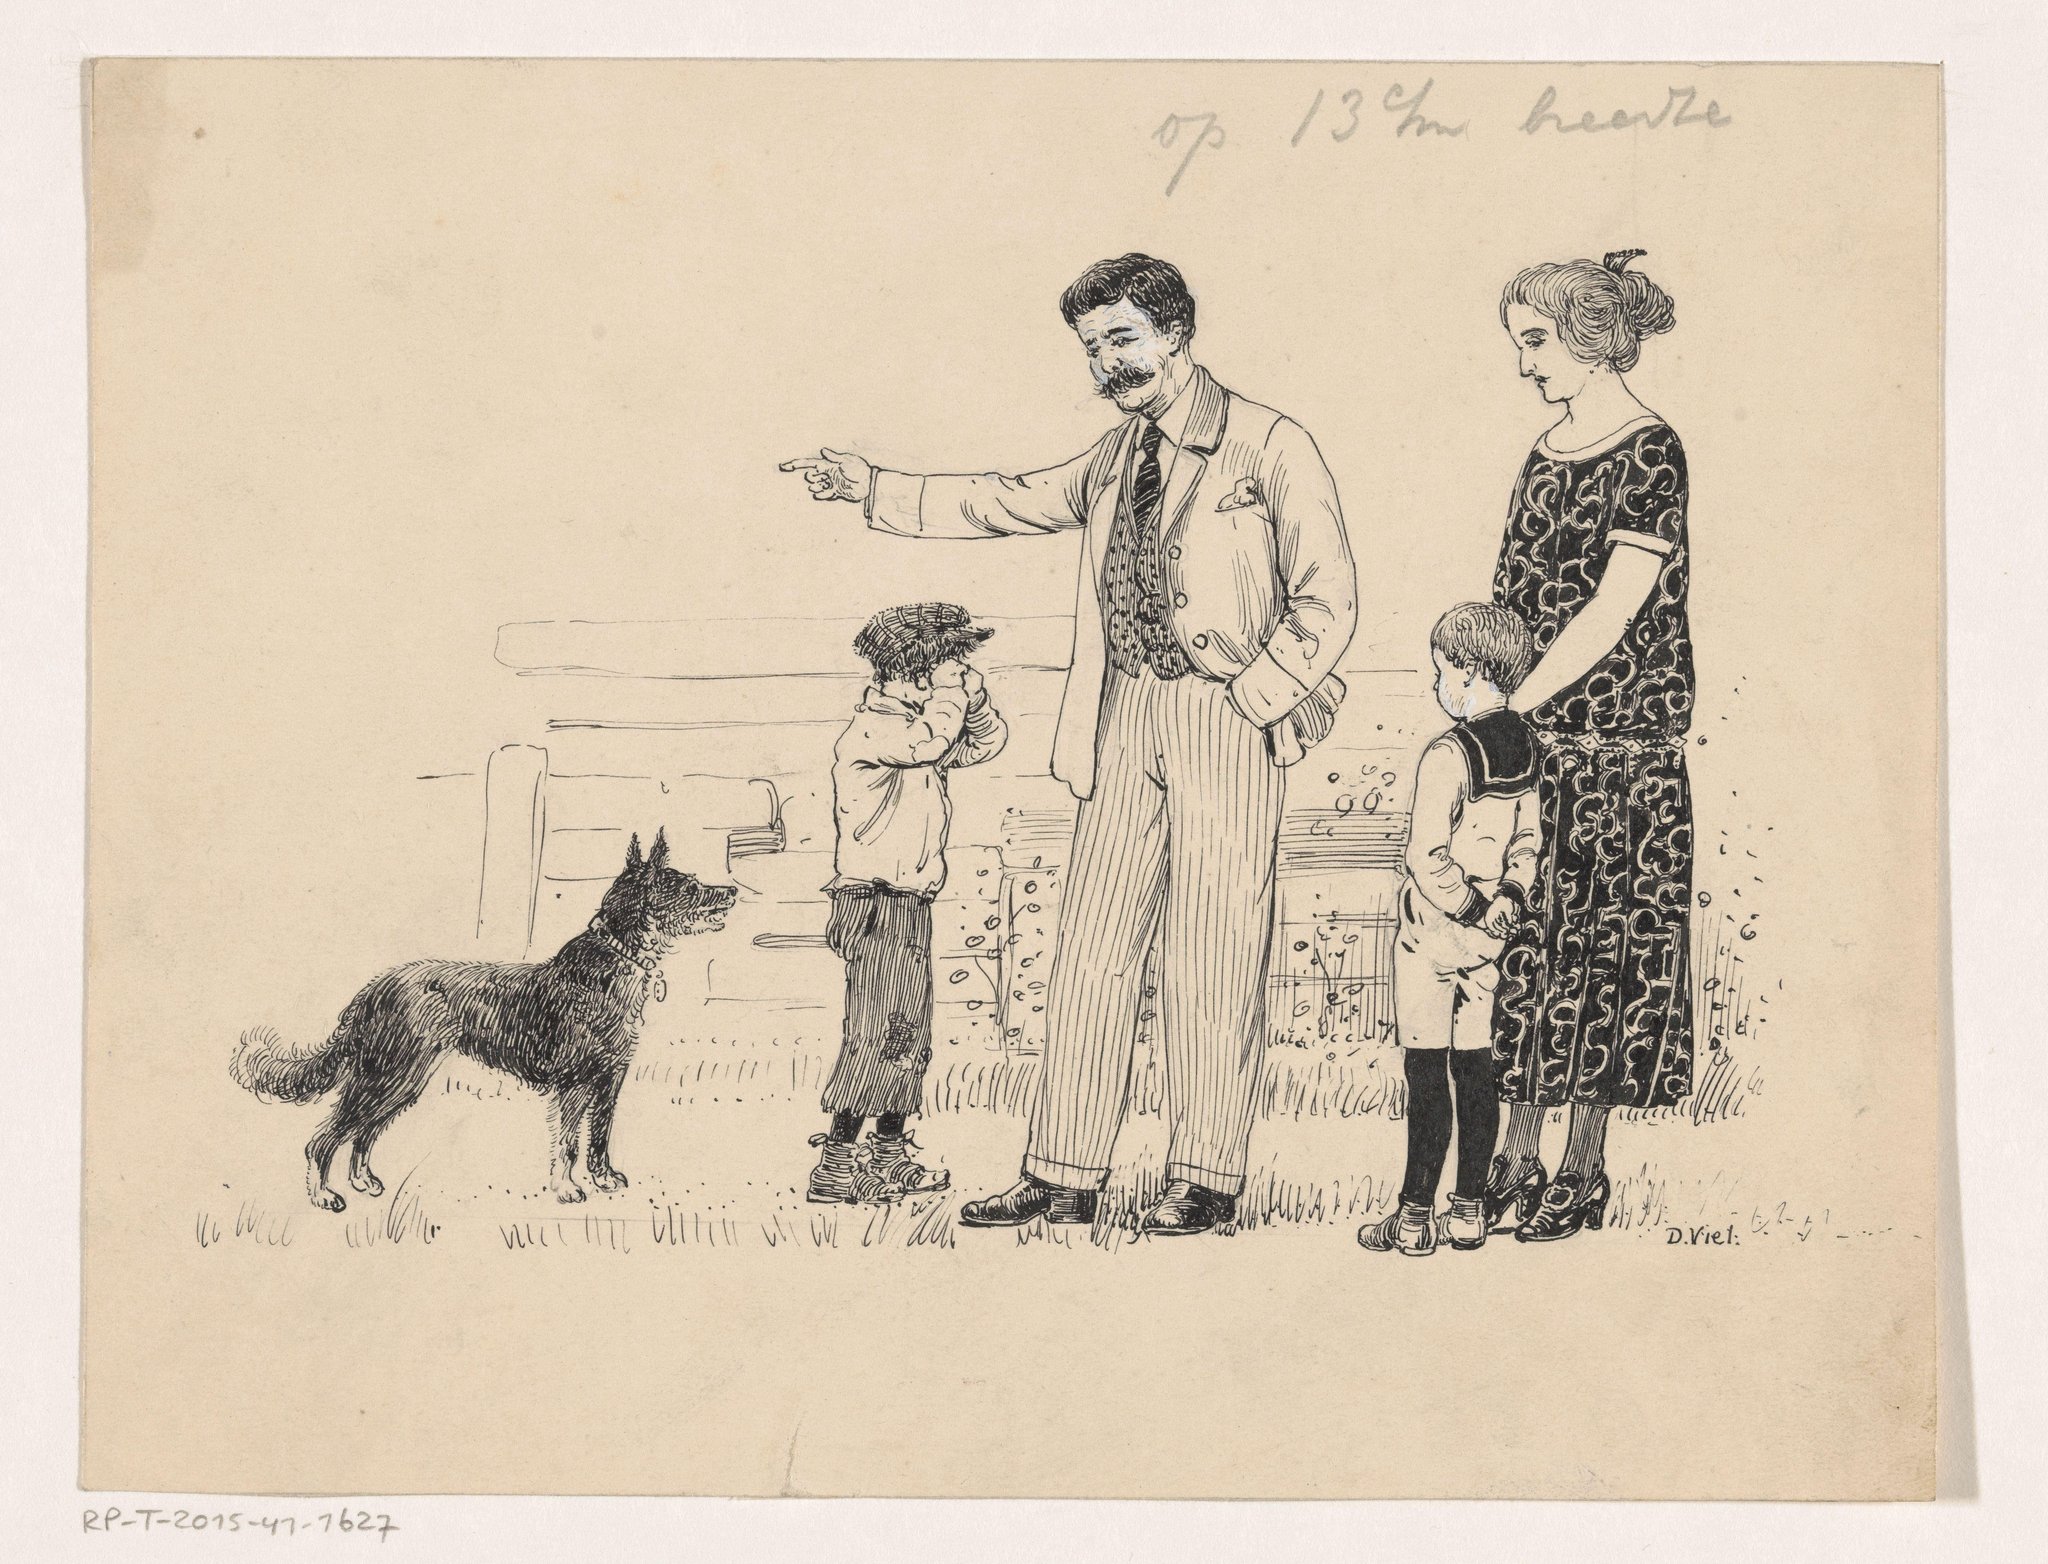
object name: drawing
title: Man wijst een jongen terecht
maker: d. viel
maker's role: draughtsman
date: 1915-1935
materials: paint, ink, paper, pencil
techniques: brush, pen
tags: rubbing one's eyes - aa - both arms or hands, index finger forwards, pointing, indicating, dog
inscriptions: :, collector's mark: Lugt 2228, signature: ‘D. Viel.’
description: In een omheinde tuin staan een man, vrouw, twee jongens en een hond. Een man wijst één van de jongens terecht. Hij steekt zijn rechterarm uit en wijst in de verte. De jongens wrijft in zijn ogen.